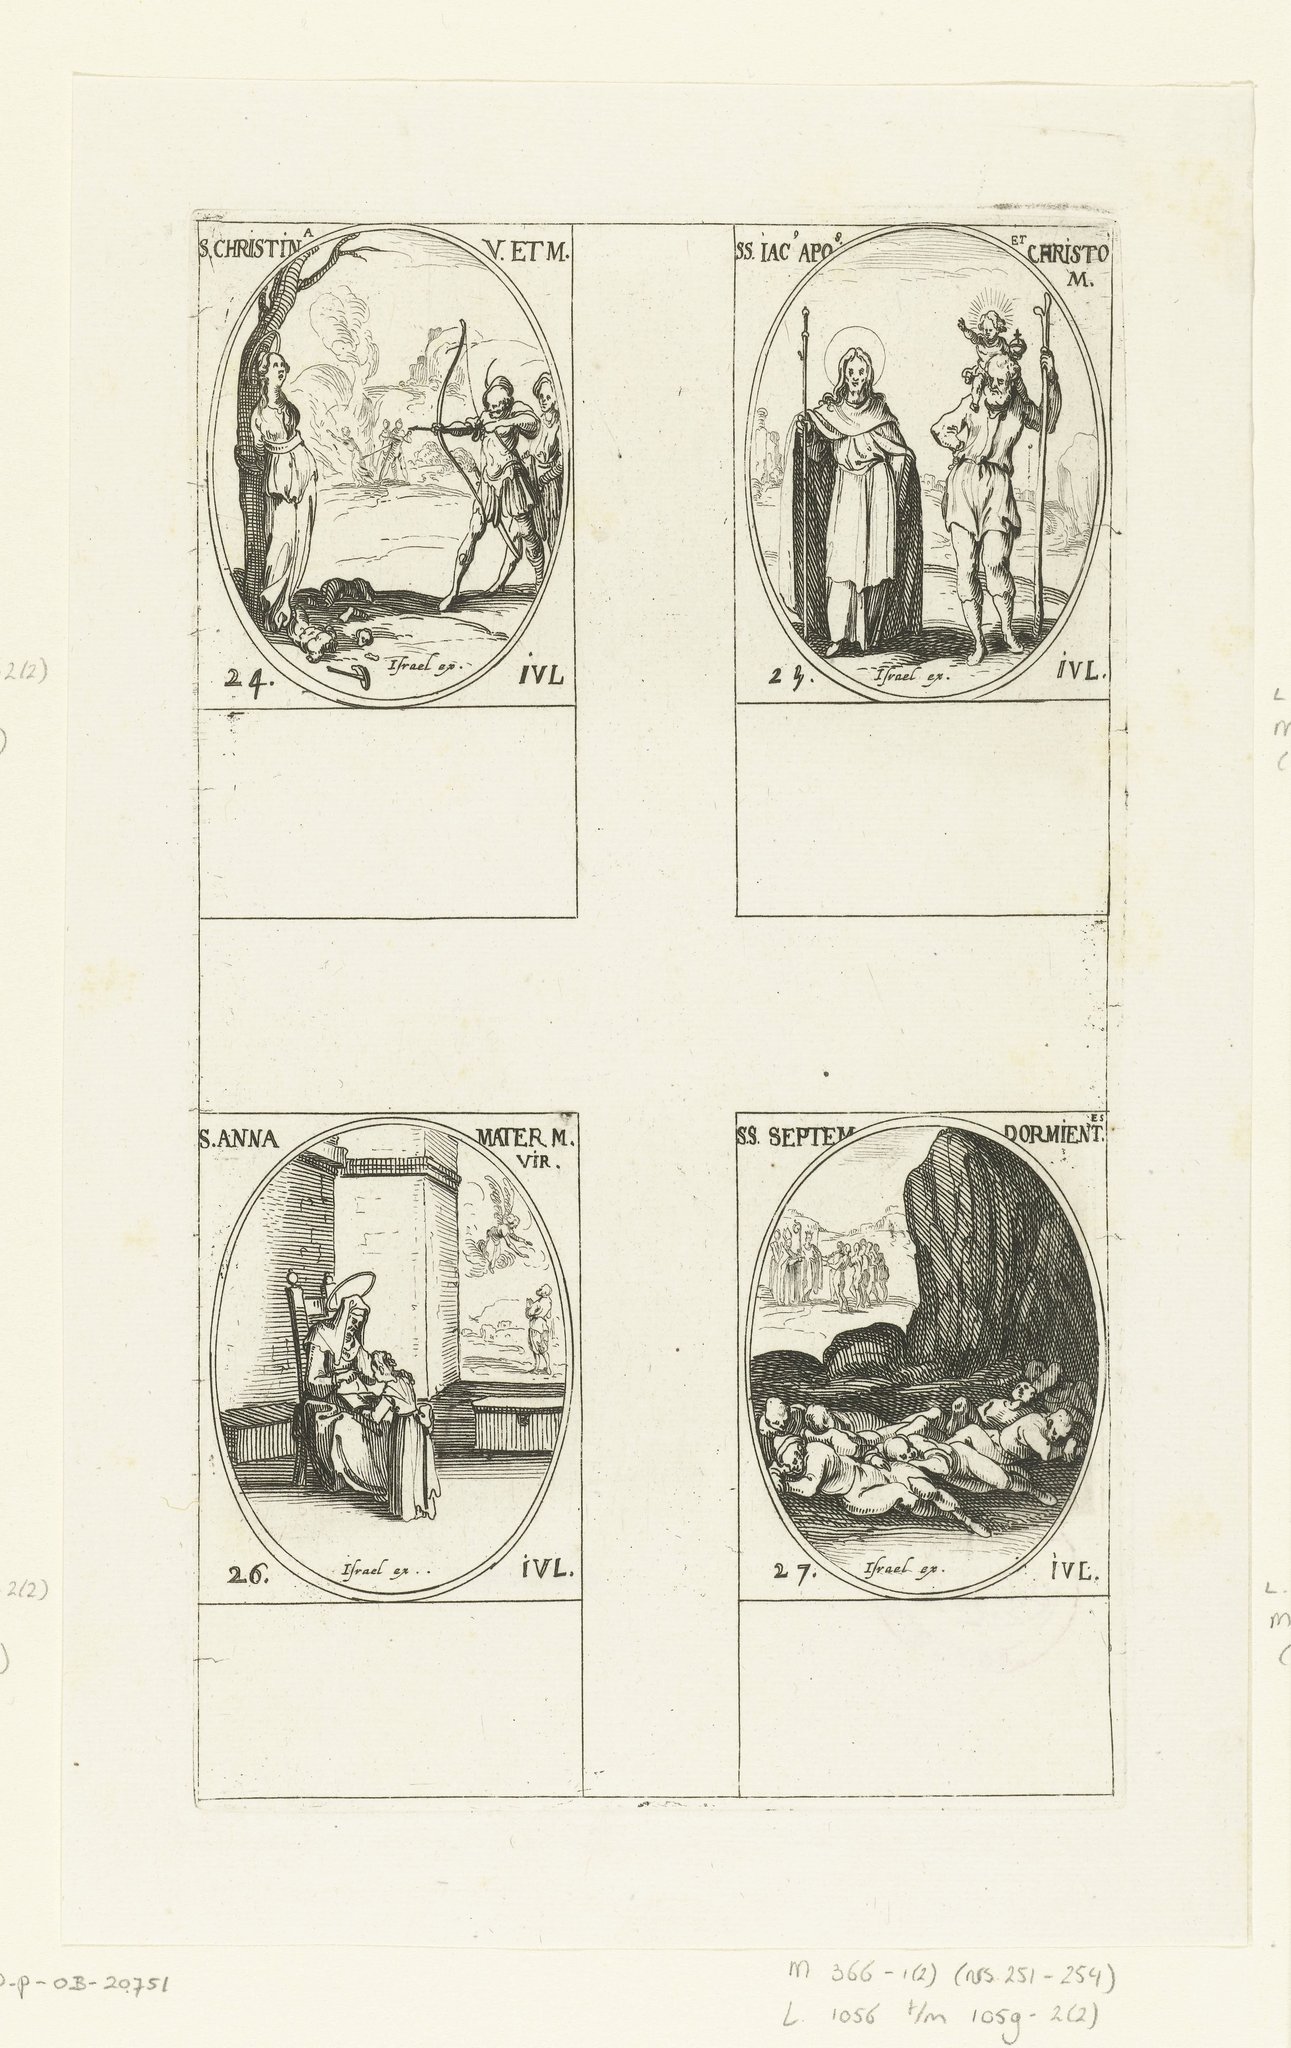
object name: print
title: Alle heiligen en de Christelijke feestdagen van het jaar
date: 1632-1636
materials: paper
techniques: etching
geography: paris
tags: anna, mother of mary; possible attributes: book, christ-child, lily, virgin mary, the seven sleepers (children) of ephesus; possible attributes: shepherd's pouch (bag), shepherd's crook, st. christina of bolsena is tied to a pillar and shot dead with arrows, the giant and martyr christophorus; possible attributes: palm-tree (with bunches of dates, or withered), infant christ, the apostle james the great; possible attributes: book, pilgrim's cloak, hat, shell, staff, and wallet, scroll, sword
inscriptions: collector's mark: Lugt 240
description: Blad met vier ovale voorstellingen, elk met opschrift en datum in het Latijn: linksboven de Heilige Christina van Bolsena die door boogschutters onder schot wordt gehouden, rechtsboven de Heilige apostel Jakobus de Meerdere met een staf naast de Heilige Christoffel met het Christuskind op de schouders, linksonder de Heilige Anna zittend op een stoel met de kleine Maria bij haar knieën, rechtsonder de Heilige Zeven slapers van Efeze liggend in een grot. Deze prent is onderdeel van een serie prenten met voorstellingen van de heiligen en de christelijke feestdagen van het jaar. Er zijn steeds vier scènes van één plaat op één blad gedrukt. Inclusief bijbehorend titelblad en frontispice gaat het in totaal om 124 platen (490 voorstellingen). De drie platen met de laatste 12 scènes (de veranderlijke christelijke feestdagen) zijn in de derde staat versneden tot 12 kleine plaatjes, en met een apart titelblad uitgegeven.